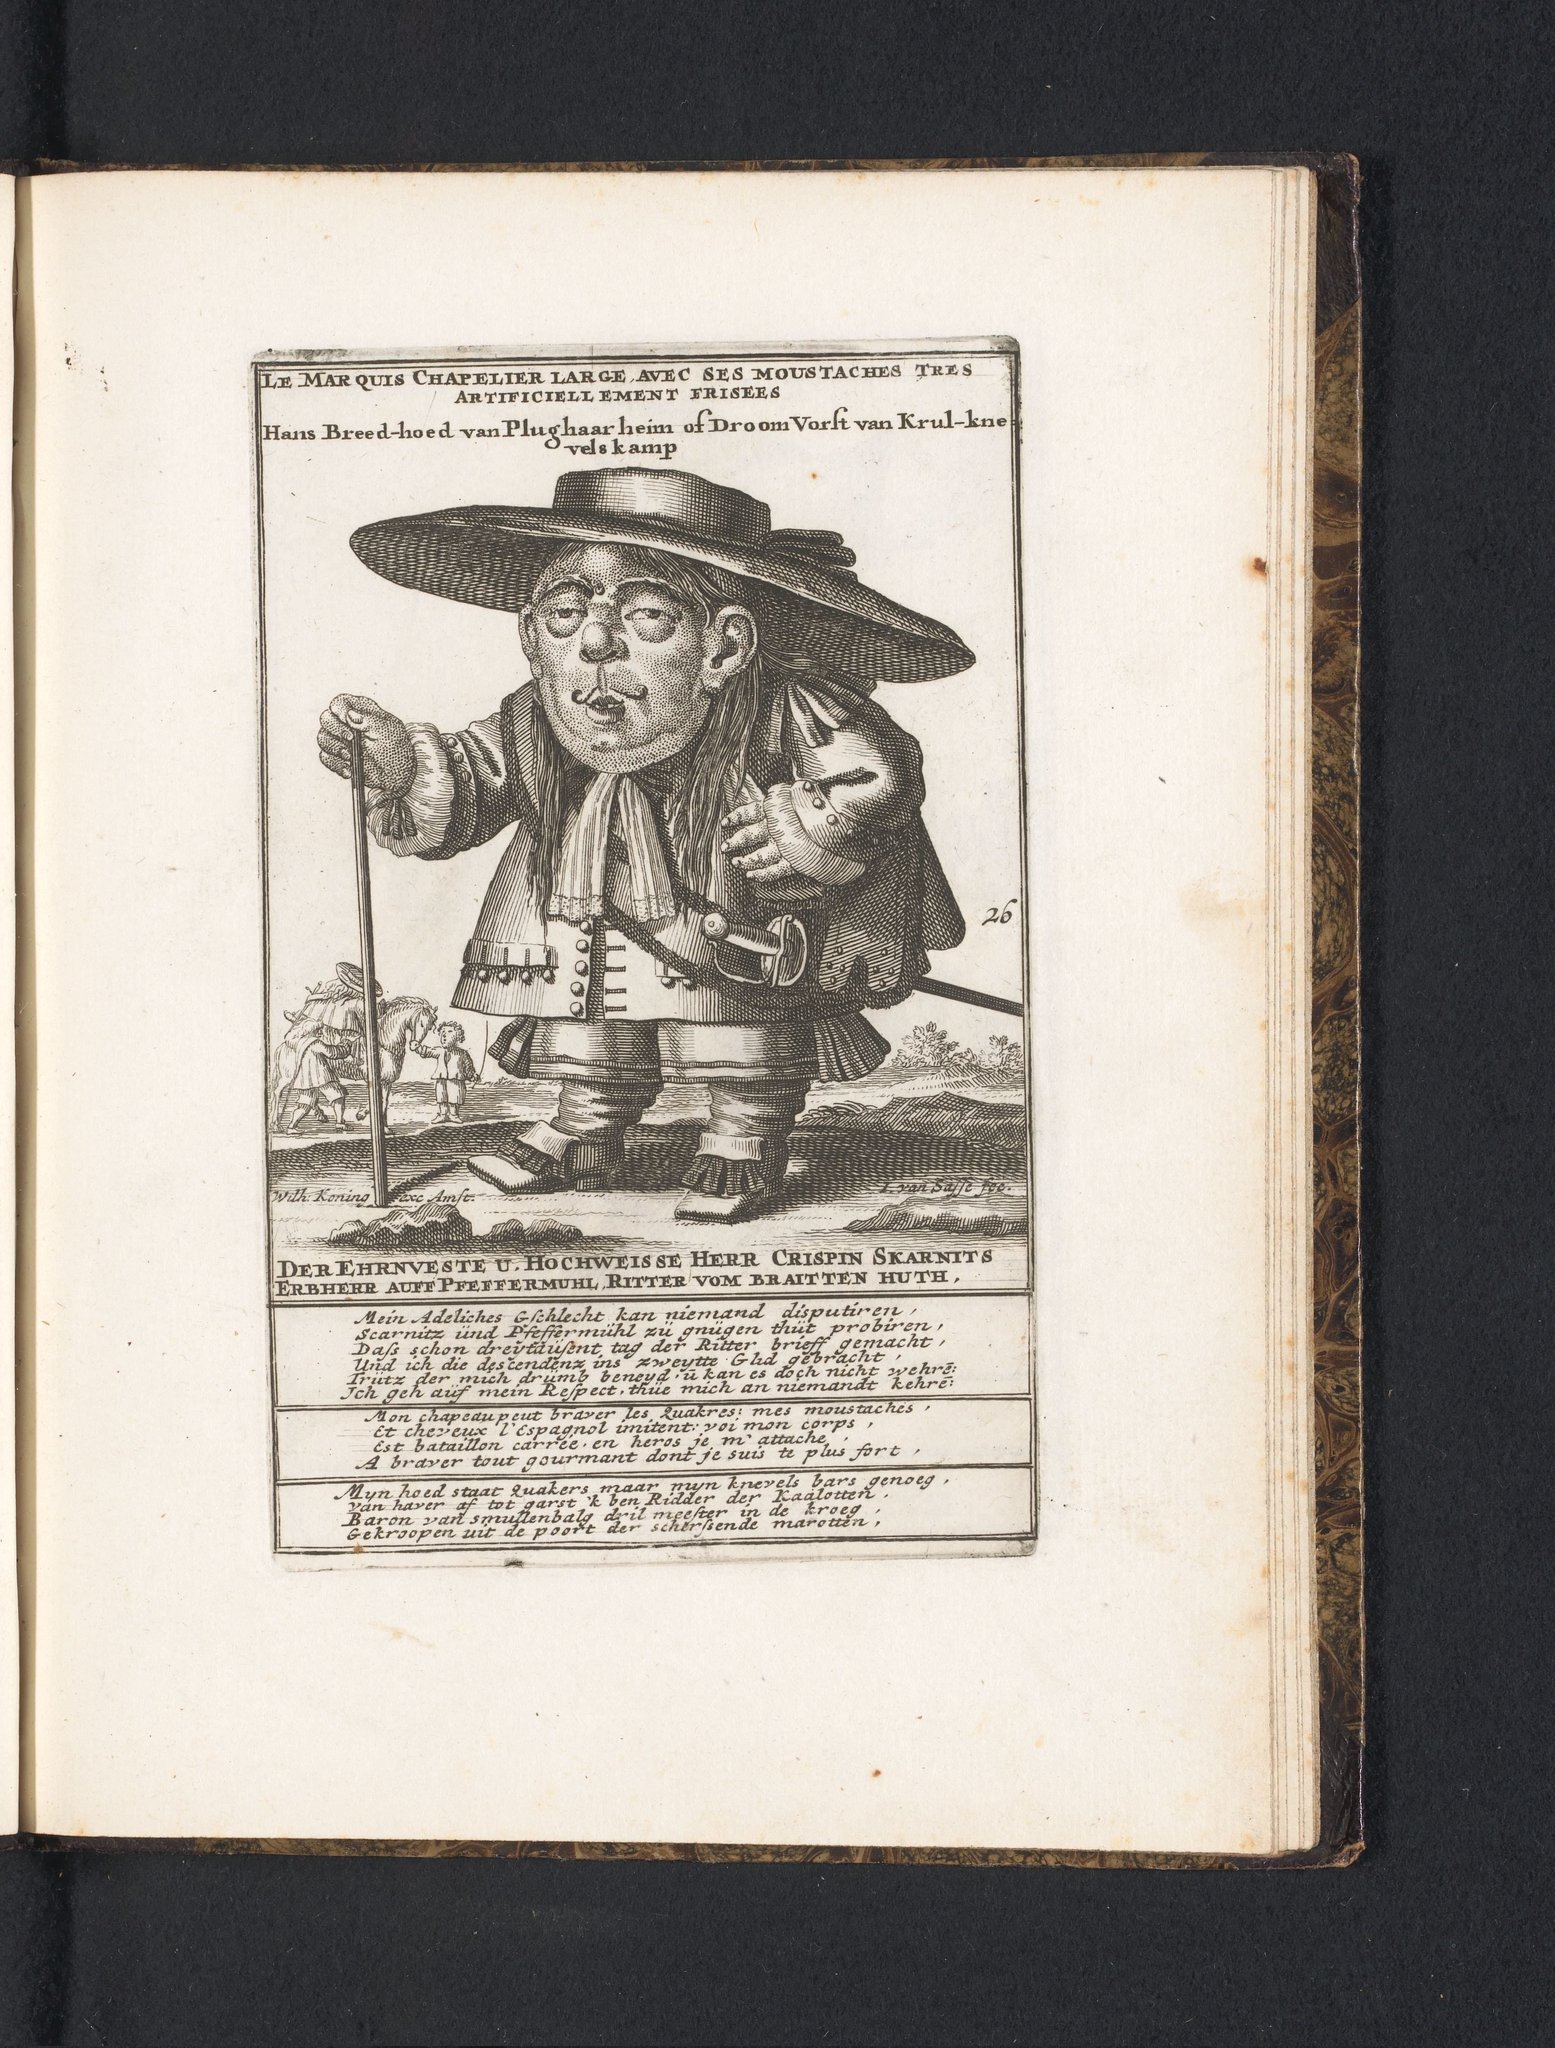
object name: print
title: De dwerg Hans Breed-hoed van Plughaarheim, 1720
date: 1718-1720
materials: paper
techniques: etching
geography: amsterdam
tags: caricatures (human types), little people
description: De kleine mens Hans Breed-hoed van Plughaarheim met brede hoed. In het onderschrift verzen in het Duits, Frans en Nederlands. Genummerd rechts midden: 26. Onderdeel van deel II in de tweede Nederlandse gebonden uitgave uit 1720 (en gerelateerd aan de Windhandel in dat jaar) van een serie karikaturen van kleine mensen, bekend als Het Dwergentooneel.